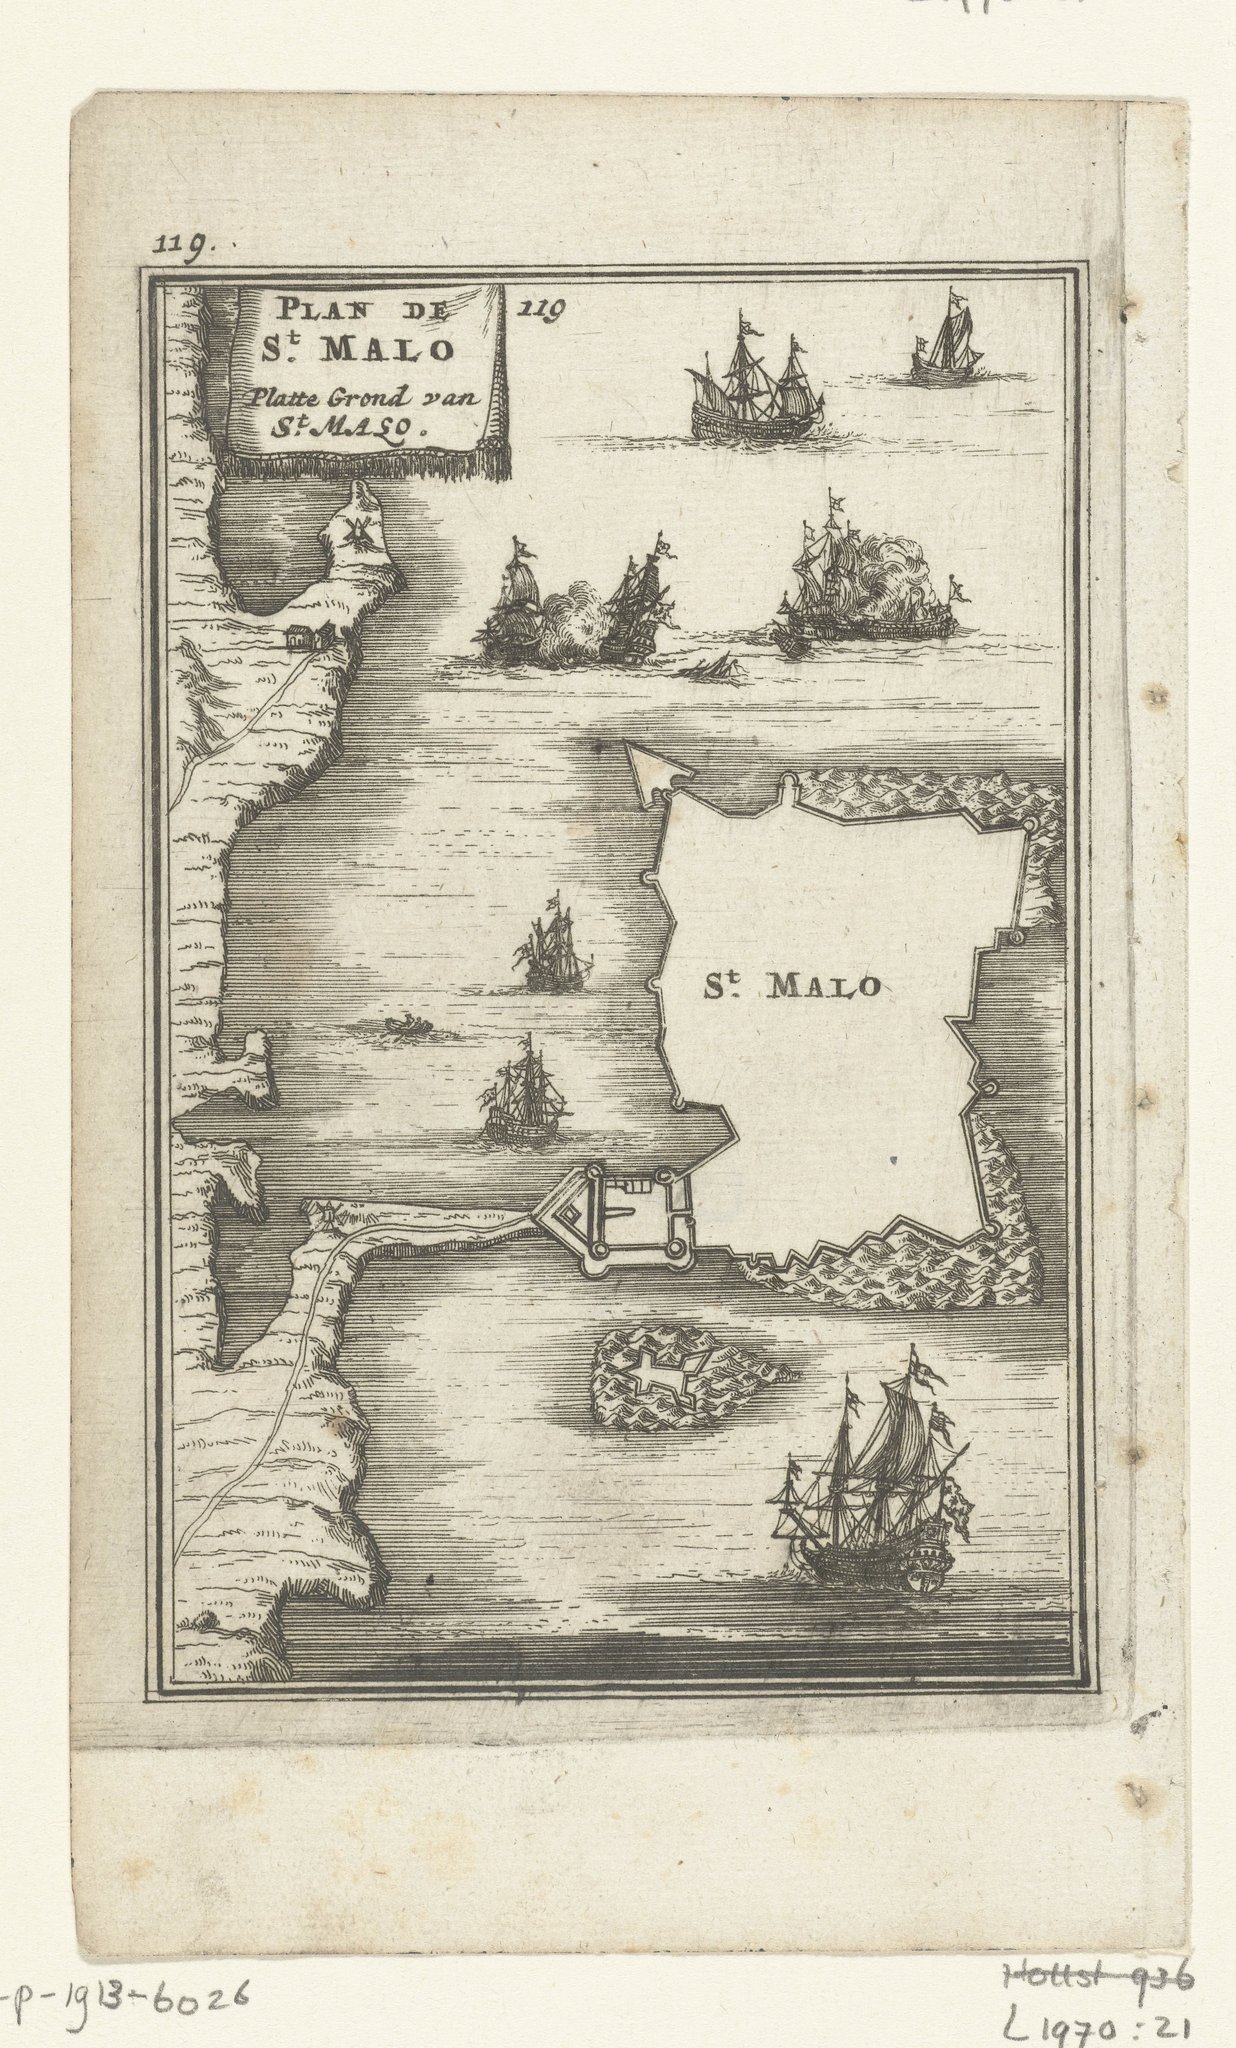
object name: print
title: Illustratie voor 'Den Arbeid van Mars' van Allain Manesson Mallet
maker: romeyn de hooghe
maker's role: draughtsman, goldsmith, painter, print maker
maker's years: 1645-1708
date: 1672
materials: paper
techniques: etching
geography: amsterdam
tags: city-view in general; 'veduta', ships (in general), sea (seascape), fortifications, military engineering, france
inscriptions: collector's mark: Lugt 2228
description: Grondplan van een vesting in zee (Saint-Malo), omringd door schepen. In de hoek linksboven tweemaal het cijfer 119 (= het nummer van de pagina in het boek waartegenover de illustratie geplaatst is).